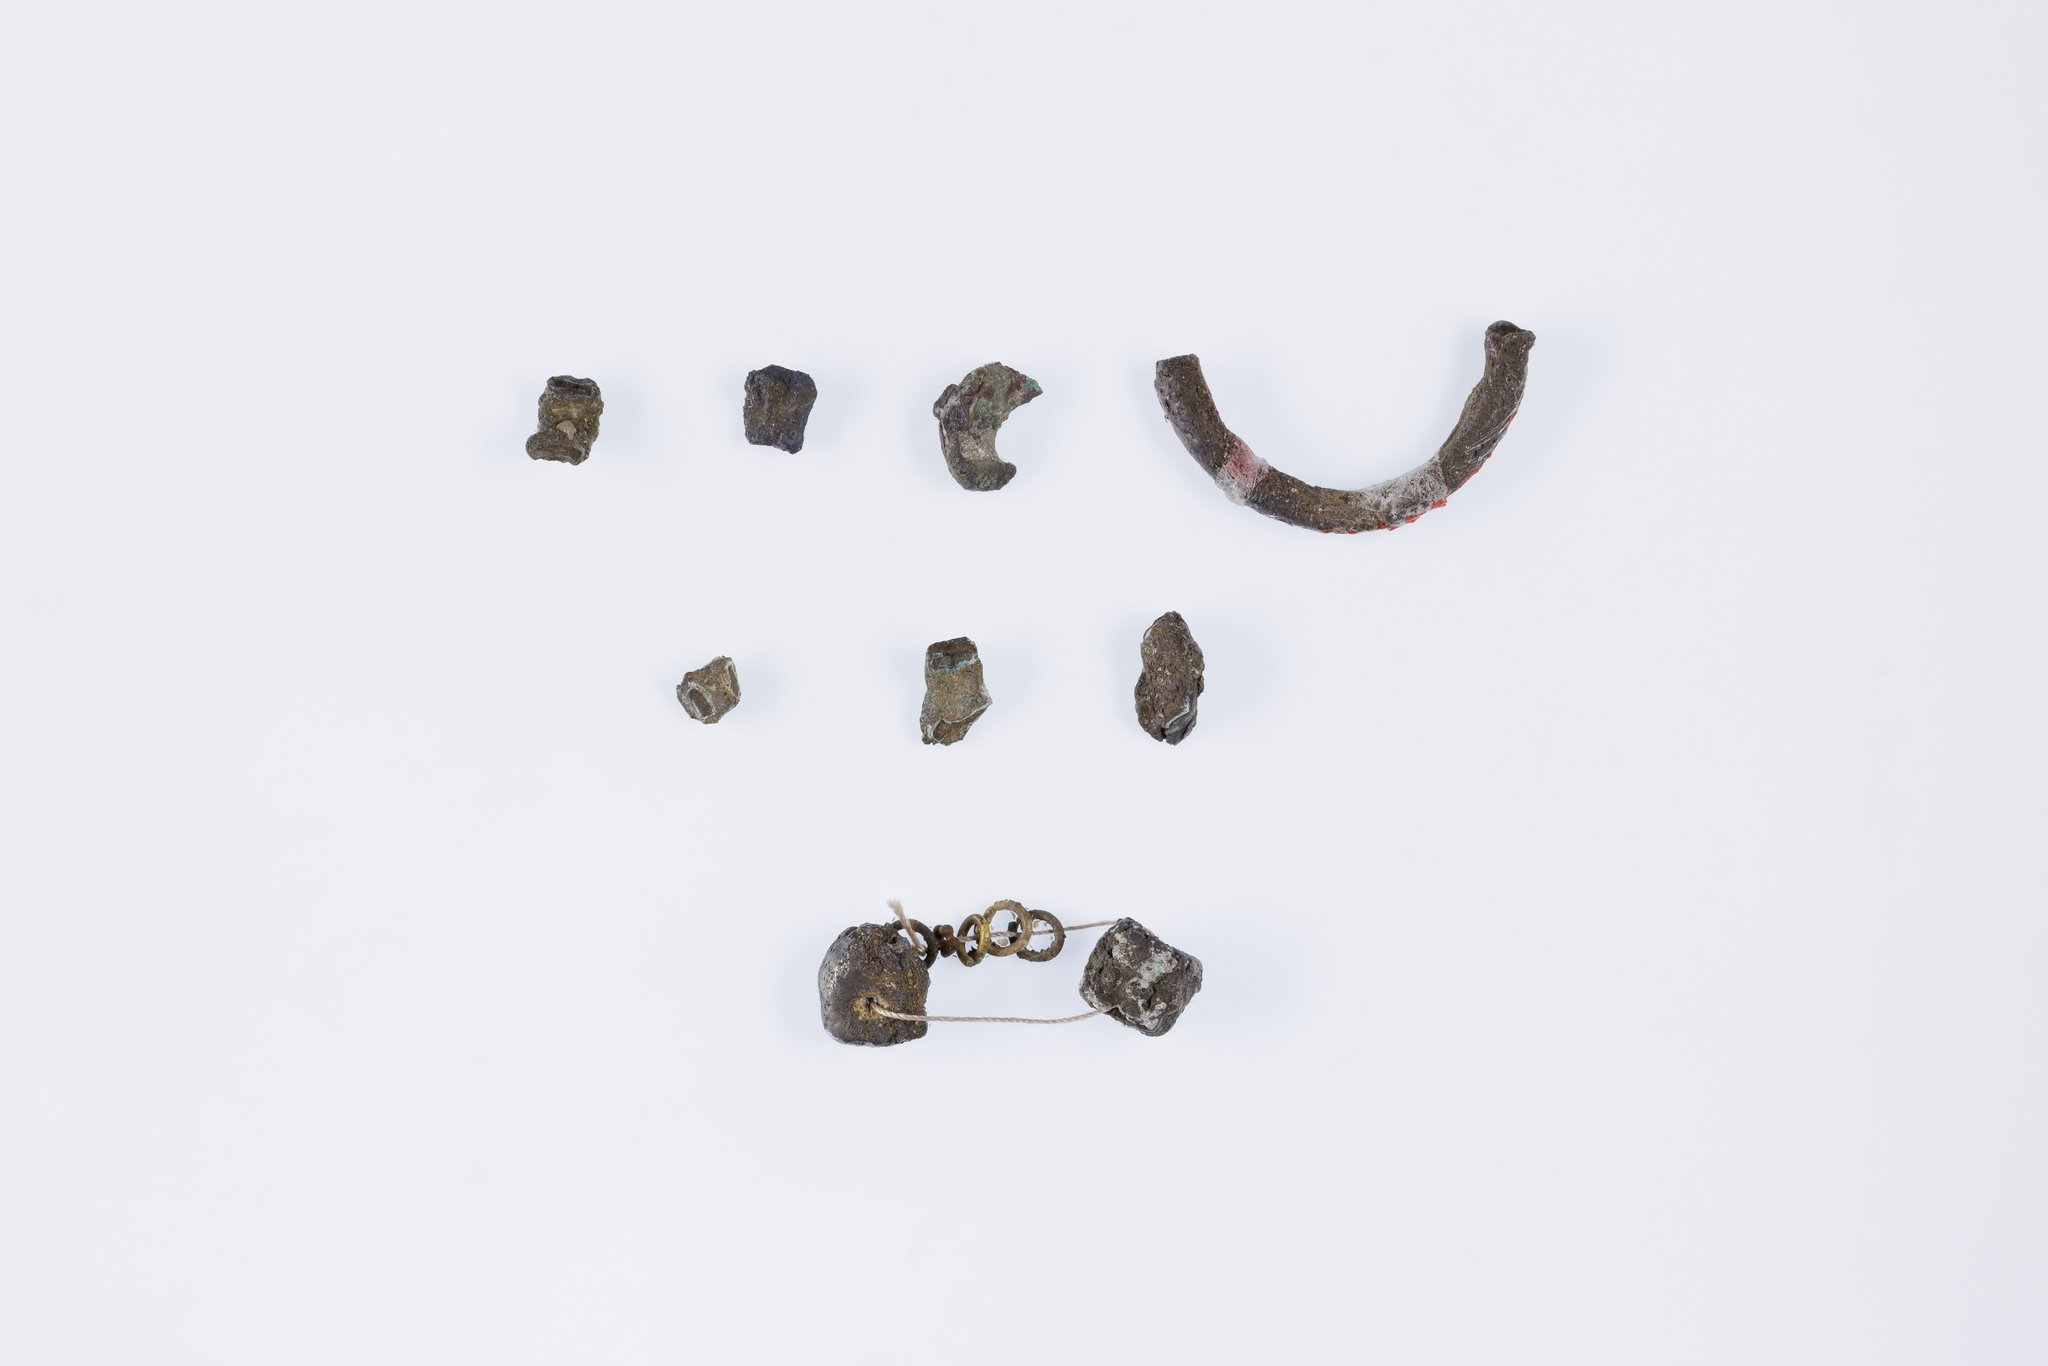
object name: vessel fragment, tell basta treasure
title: Beads and fragments of a ring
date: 1070-712 BCE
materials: silver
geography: egypt